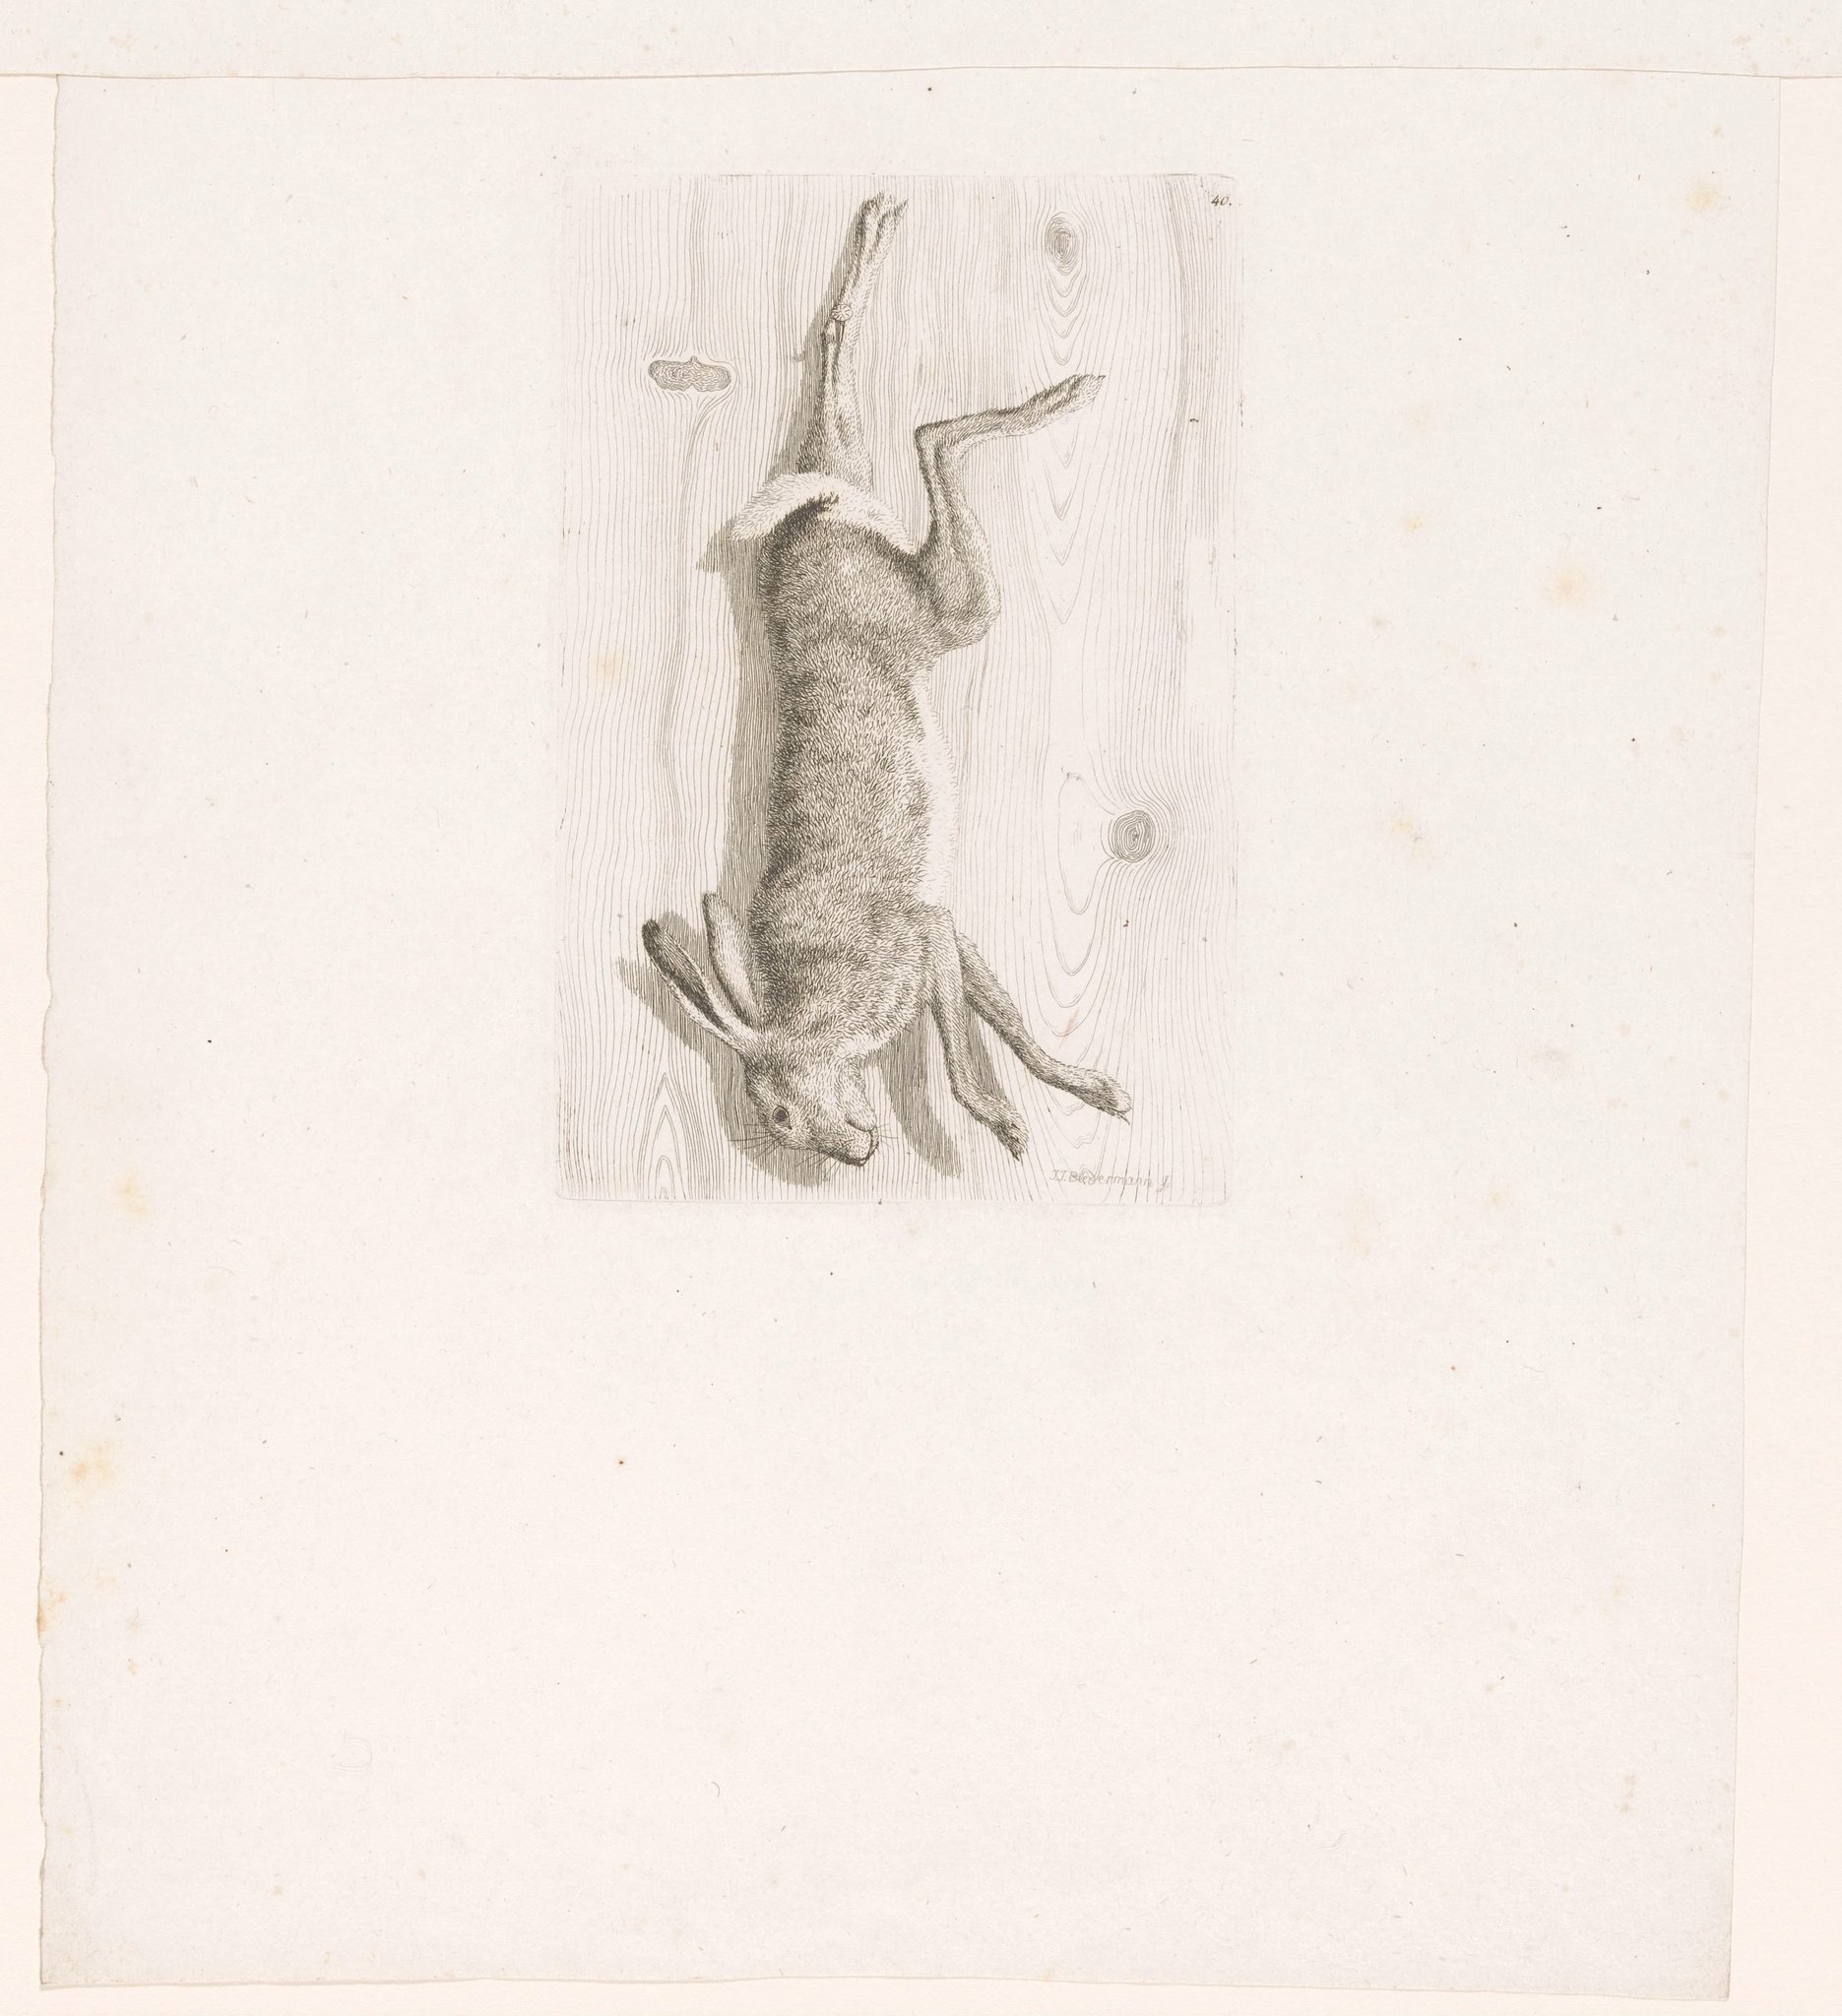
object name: print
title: Dode haas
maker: johan jakob biedermann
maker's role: painter, print maker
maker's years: 1763-1830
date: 1778-1830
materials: paper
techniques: etching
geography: switzerland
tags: rodents (with name) (+ dying animal; death of animal; dead animal)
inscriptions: collector's mark: Lugt 2228, watermark: ‘Thurneisen’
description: Dode haas, vastgespijkerd tegen een houten wand. Rechtsboven genummerd: 40.